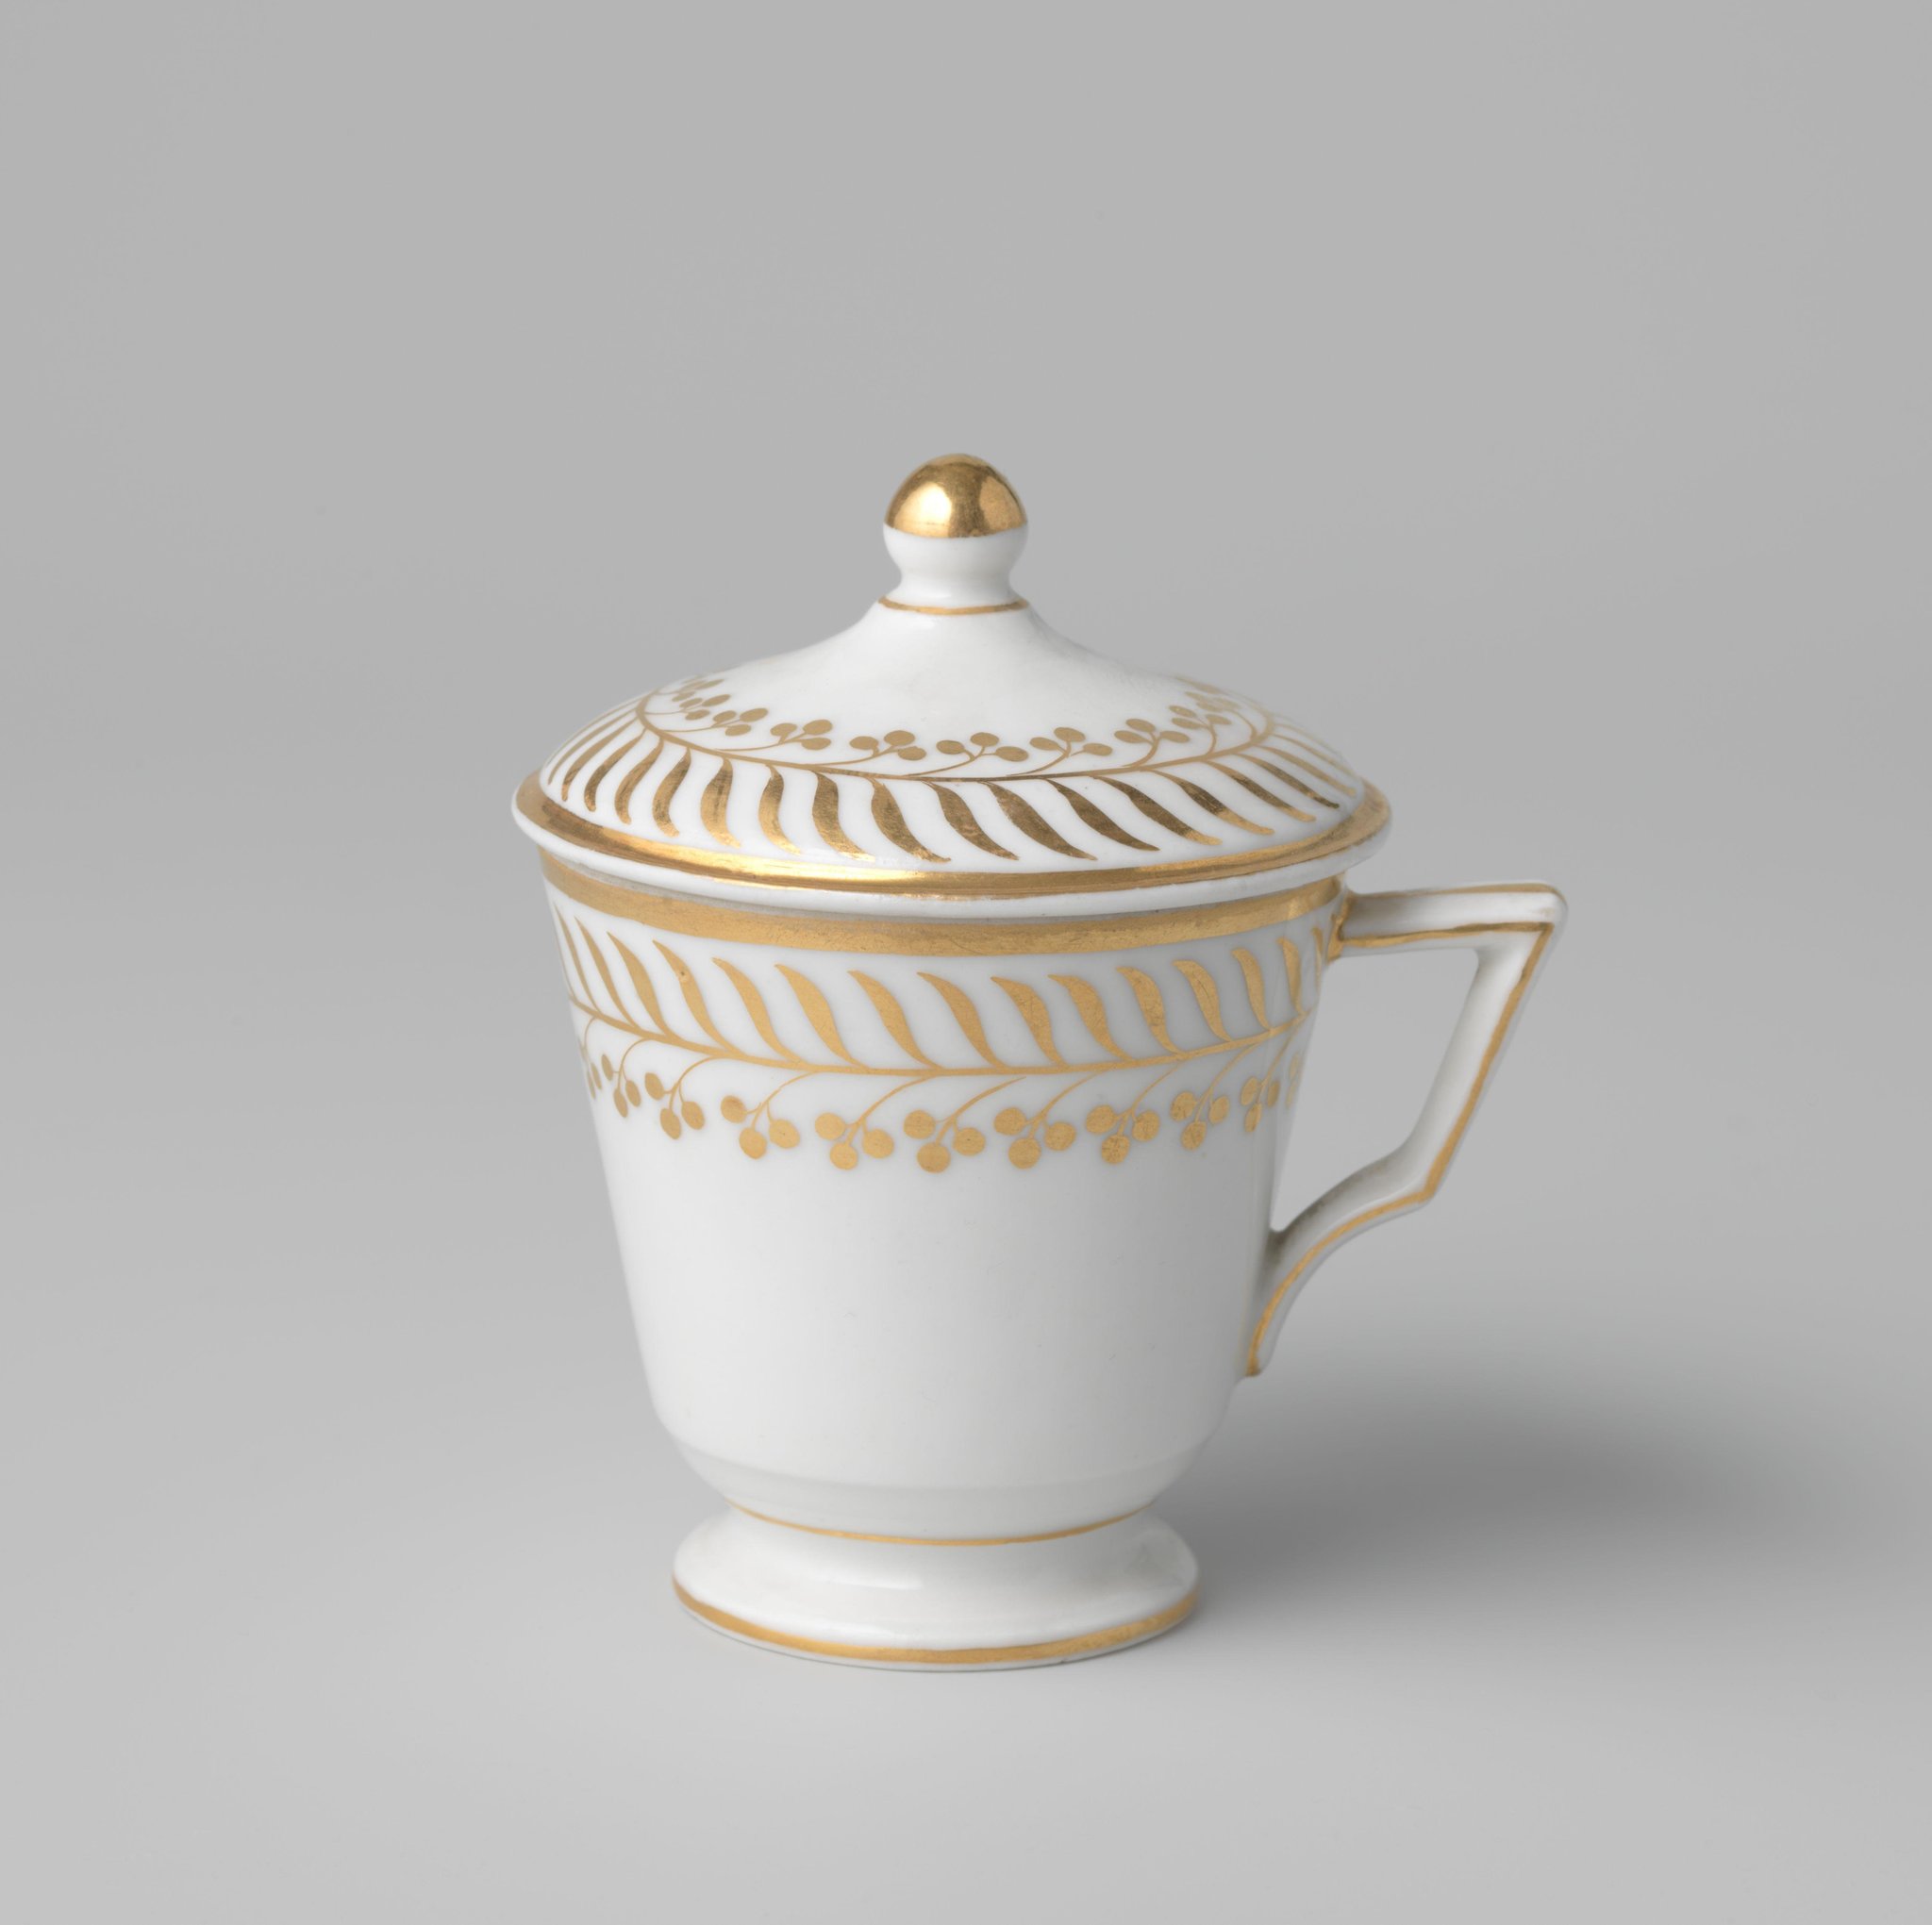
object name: service set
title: Covered cup (pot de crème) with stylized floral scrolls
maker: Anonymous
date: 1800-1810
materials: glaze, gold, paint, porcelain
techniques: firing, forming, gilding, vitrification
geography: france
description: Crêmepot van porselein met oor. Versierd met gouden biezen en langs de randen beschilderd met een doorlopende tak met aan de ene zijde bladeren, aan de andere zijde steeds een tak met drie vruchten. Gemerkt met ingegrifte 1.